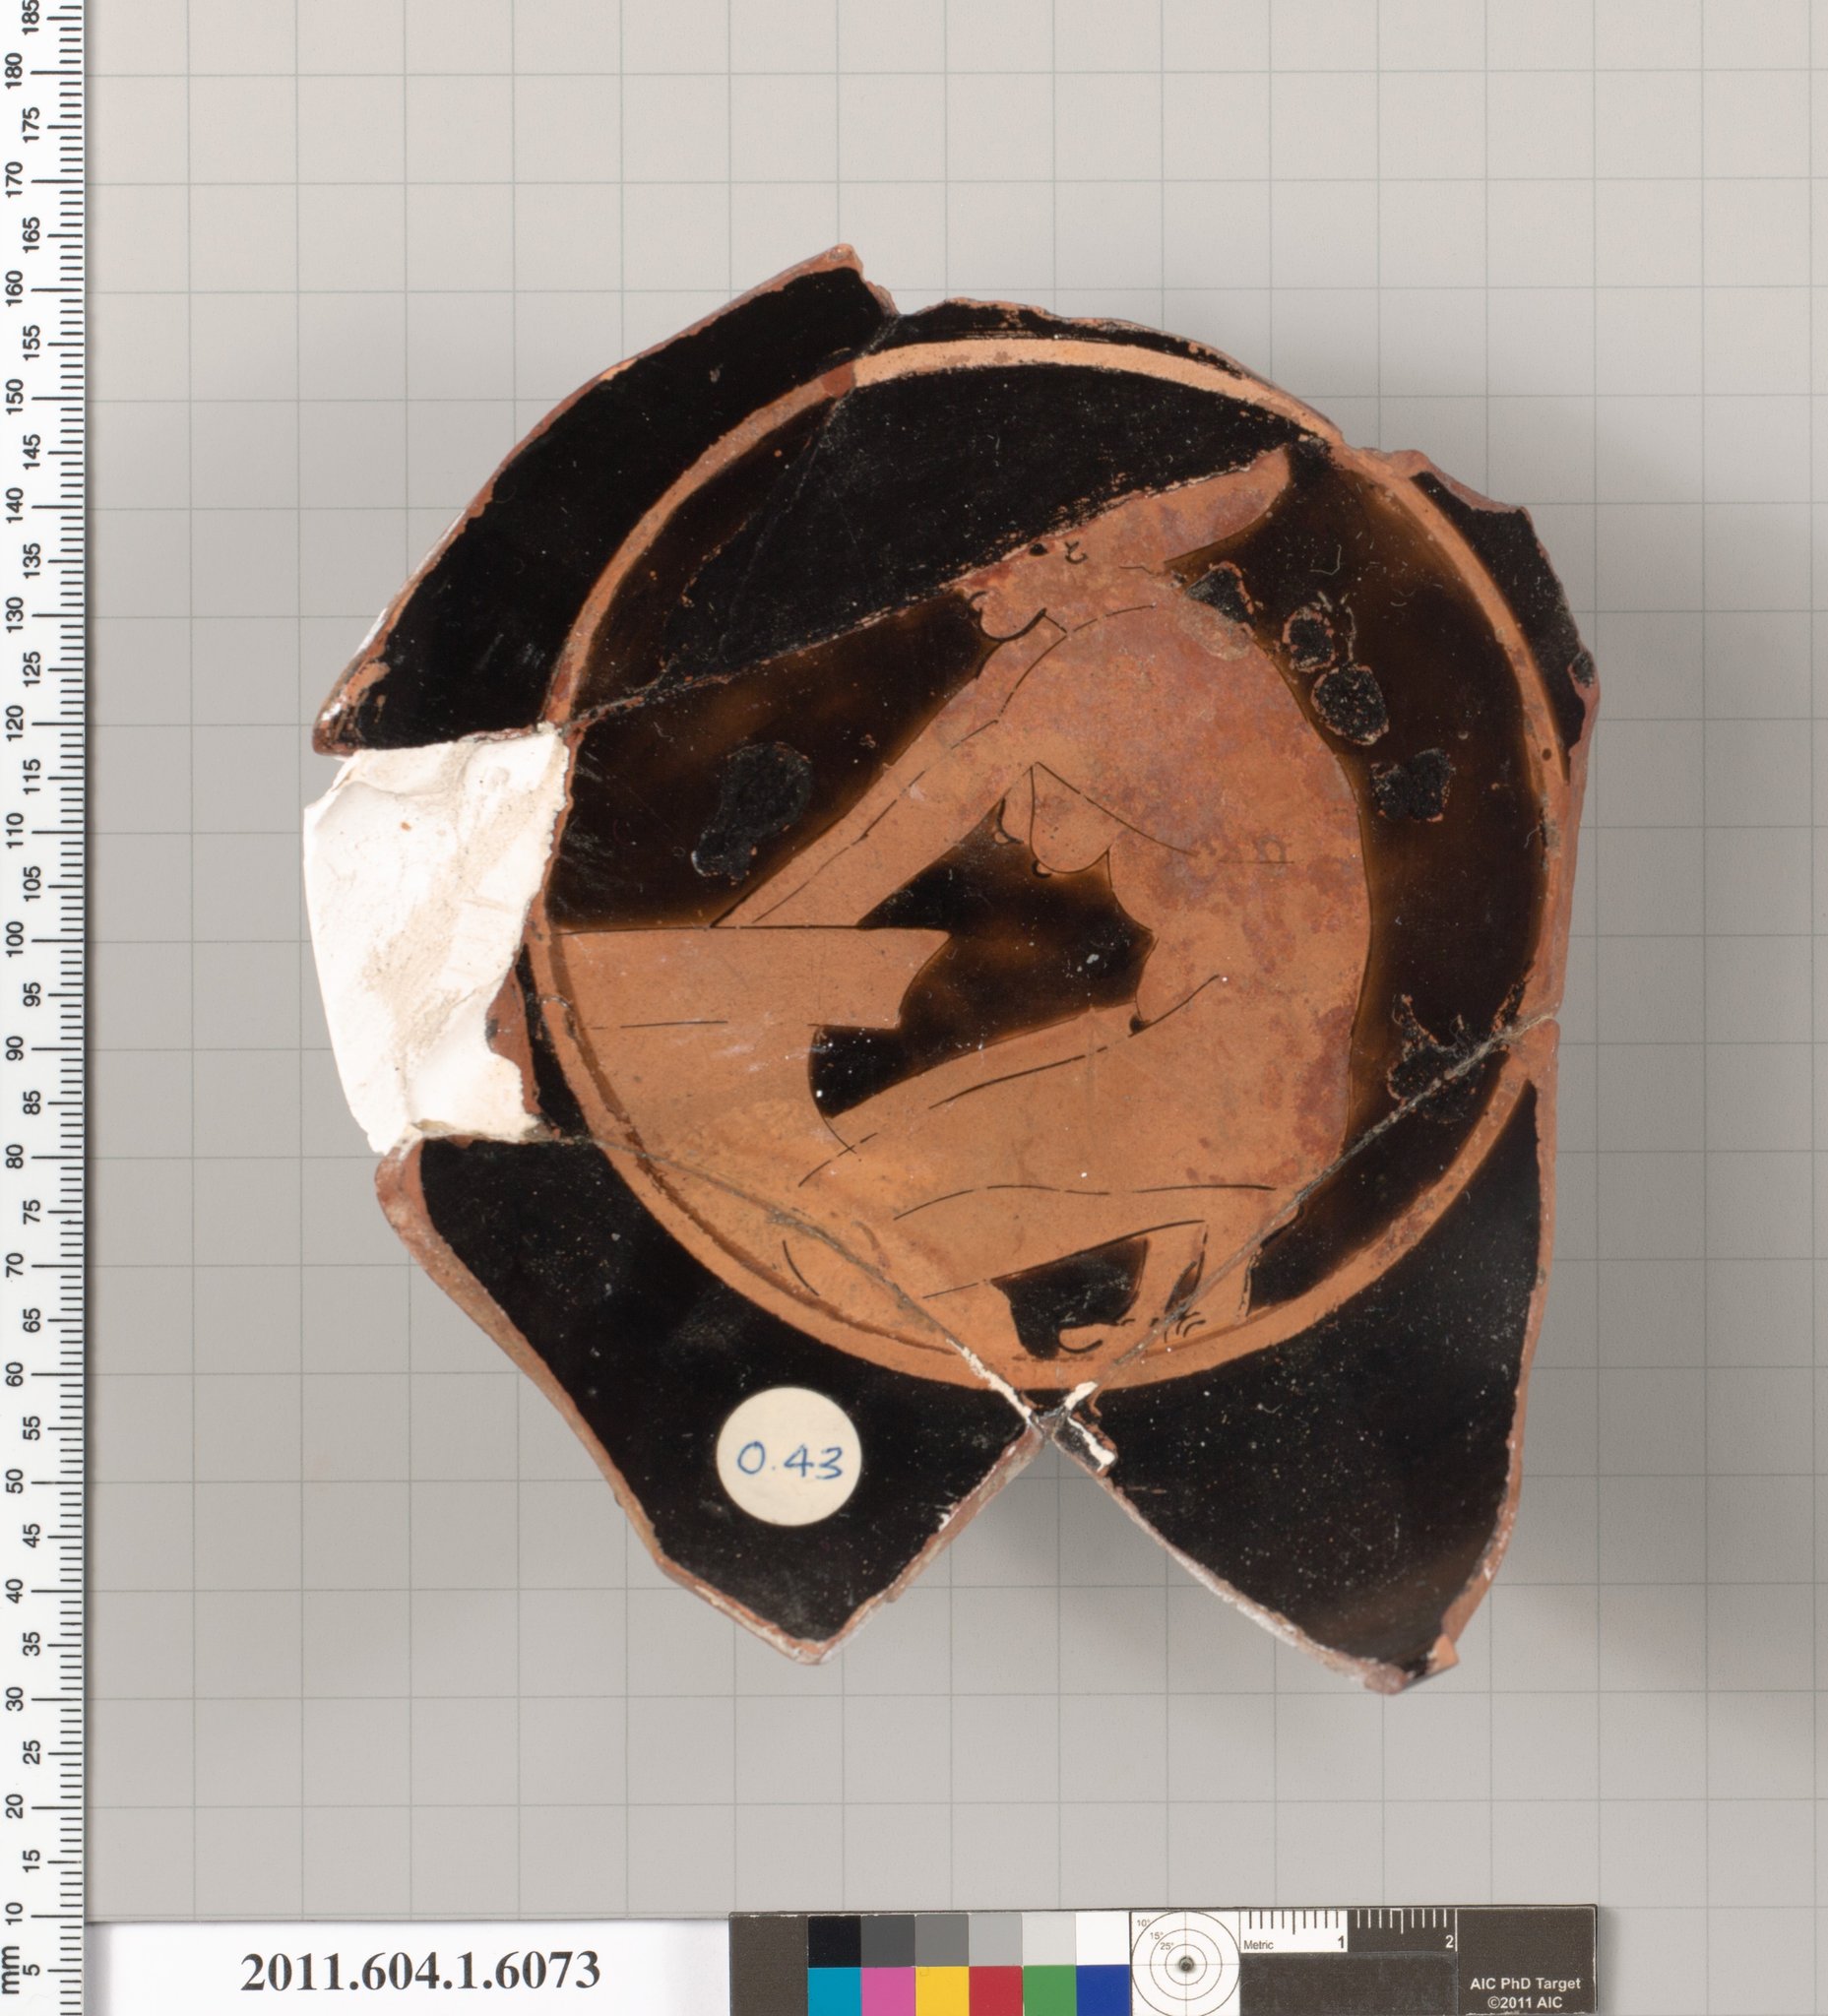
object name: kylix fragment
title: Terracotta fragment of a kylix (drinking cup)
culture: greek, attic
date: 510-500 BCE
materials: terracotta